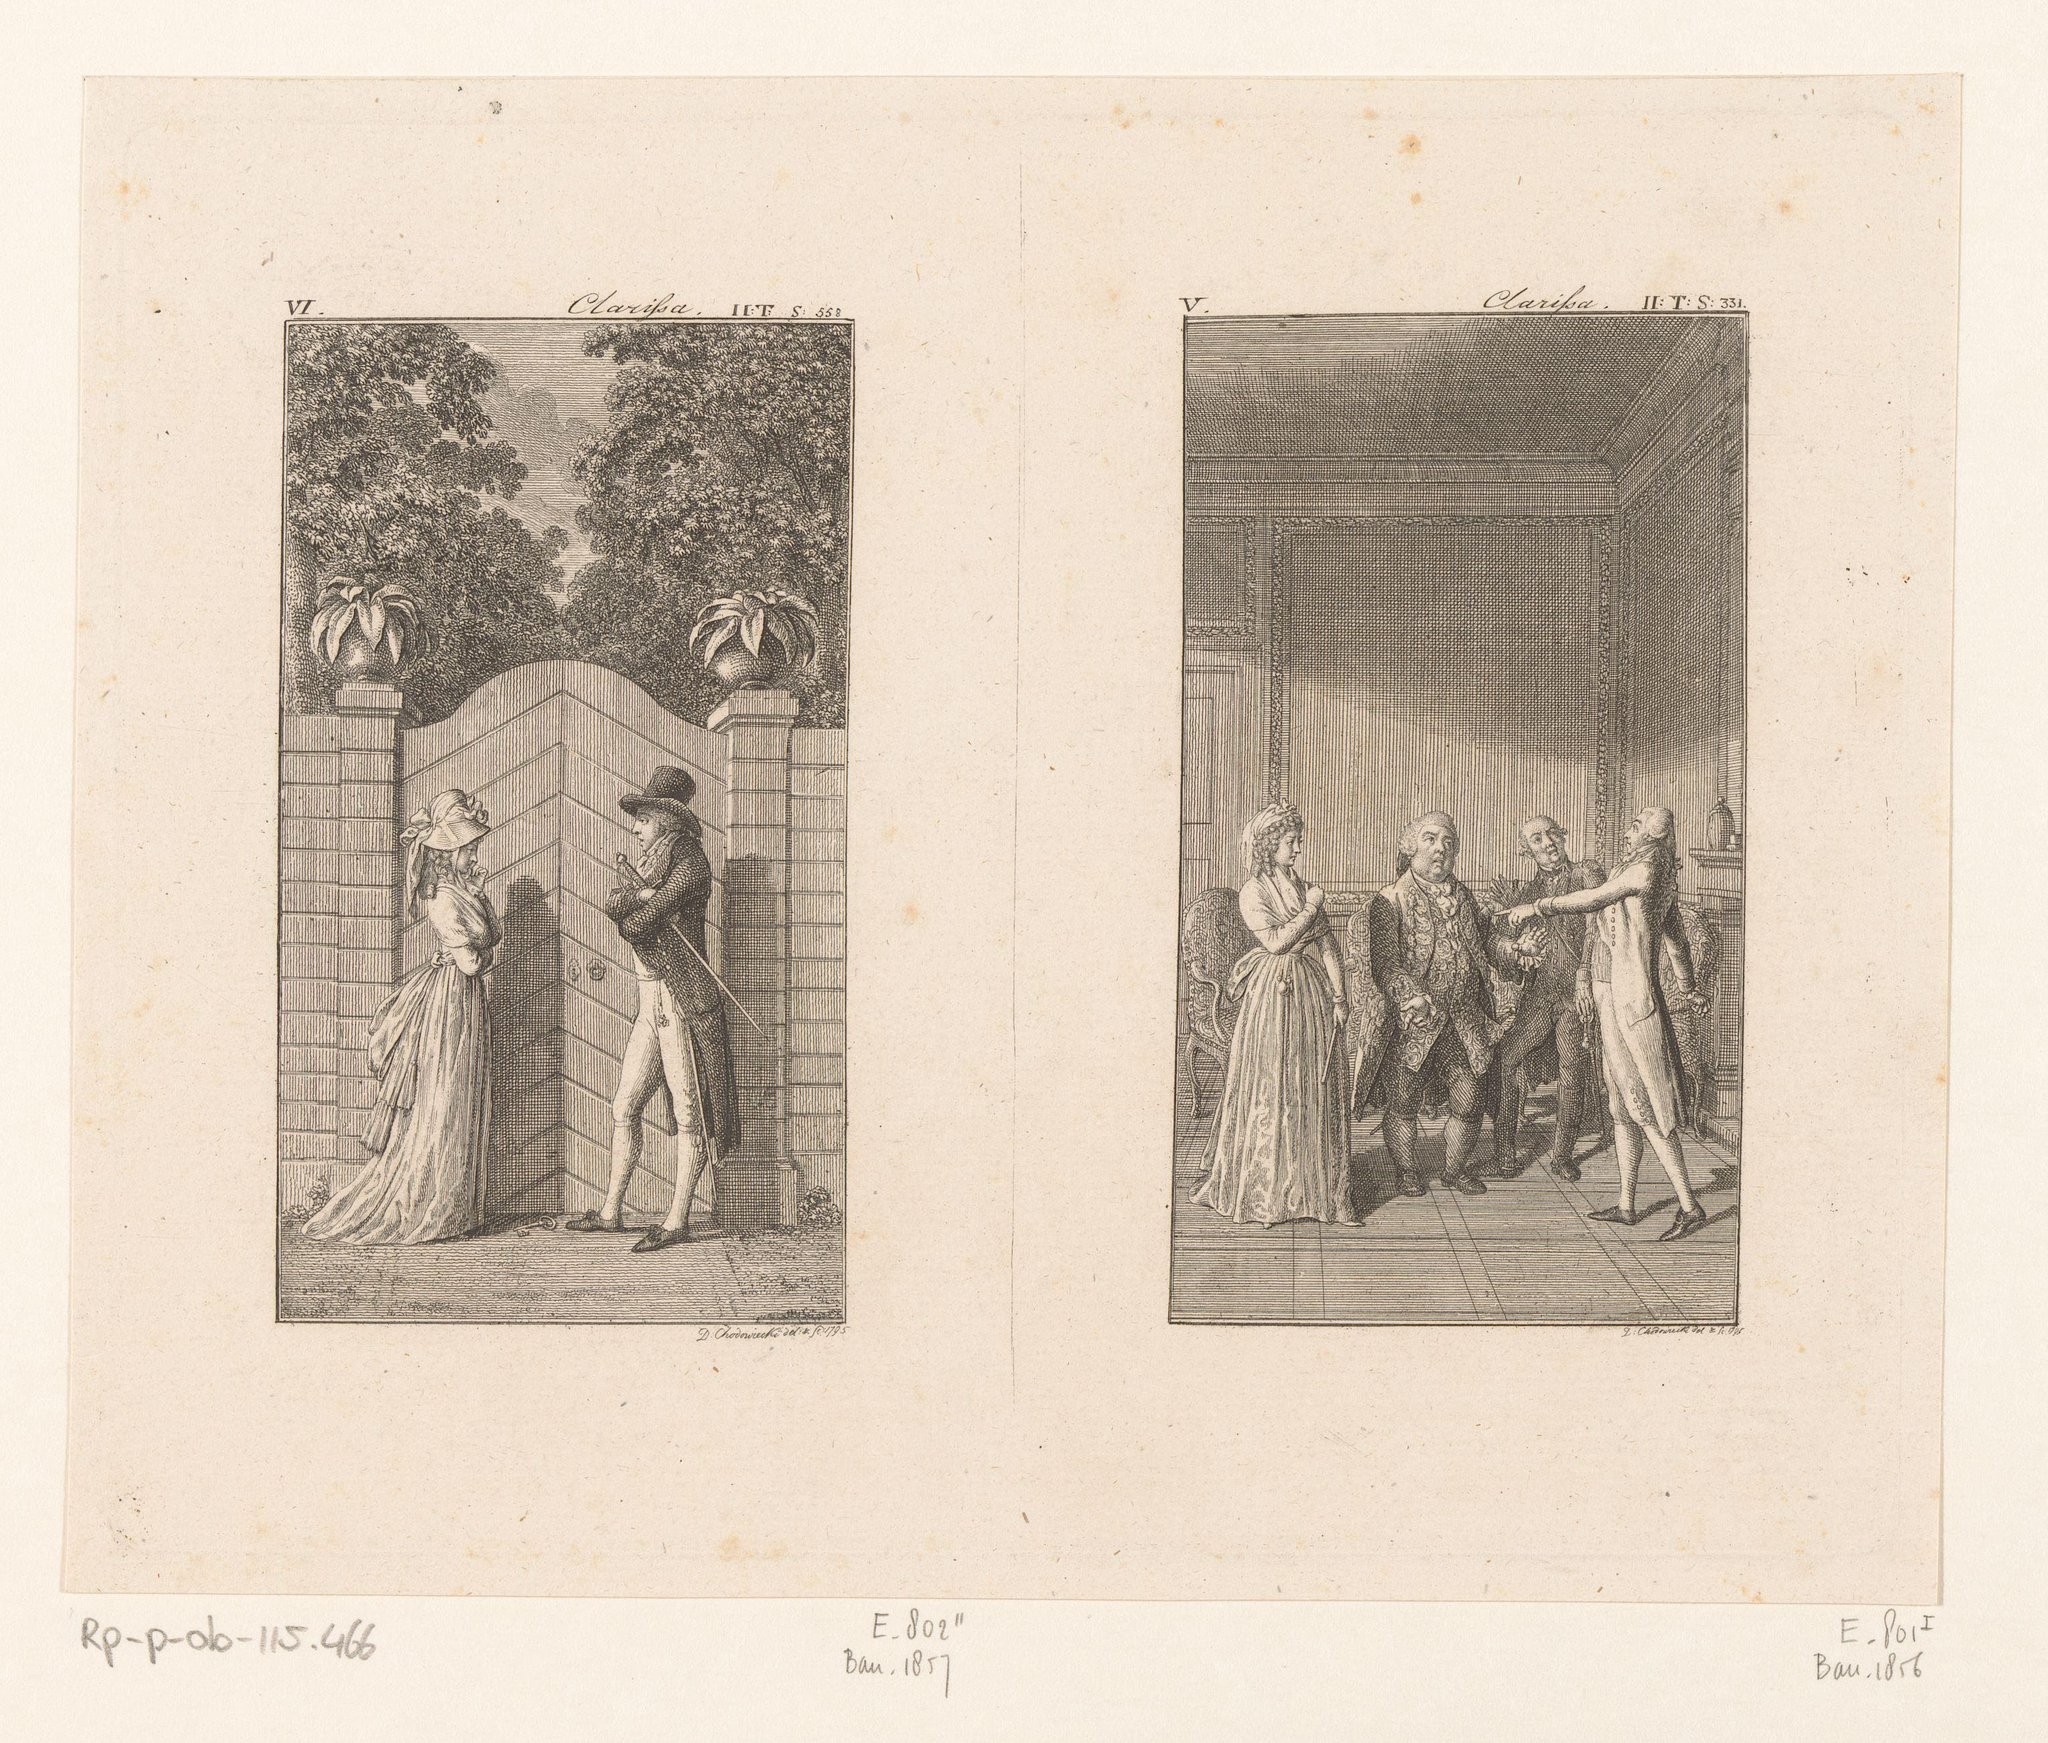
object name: print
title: Twee voorstellingen uit Clarissa van Samuel Richardson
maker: daniel nikolaus chodowiecki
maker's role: draughtsman, print maker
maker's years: 1726-1801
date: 1795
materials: paper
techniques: etching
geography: berlin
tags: literature, key, gate, entrance, index finger forwards, pointing, indicating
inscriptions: collector's mark: Lugt 2228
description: Prenten gebruikt voor: Richardson, Samuel. Clarissens Schicksale dargestellt in vier und zwanzig Kupferblättern von Daniel Chodowiecki. mit Erläuterungen des Deutschen Uebersetzers Dr. L. Th. Kosegarten. Leipzig: Heinrich Gräff, 1796.